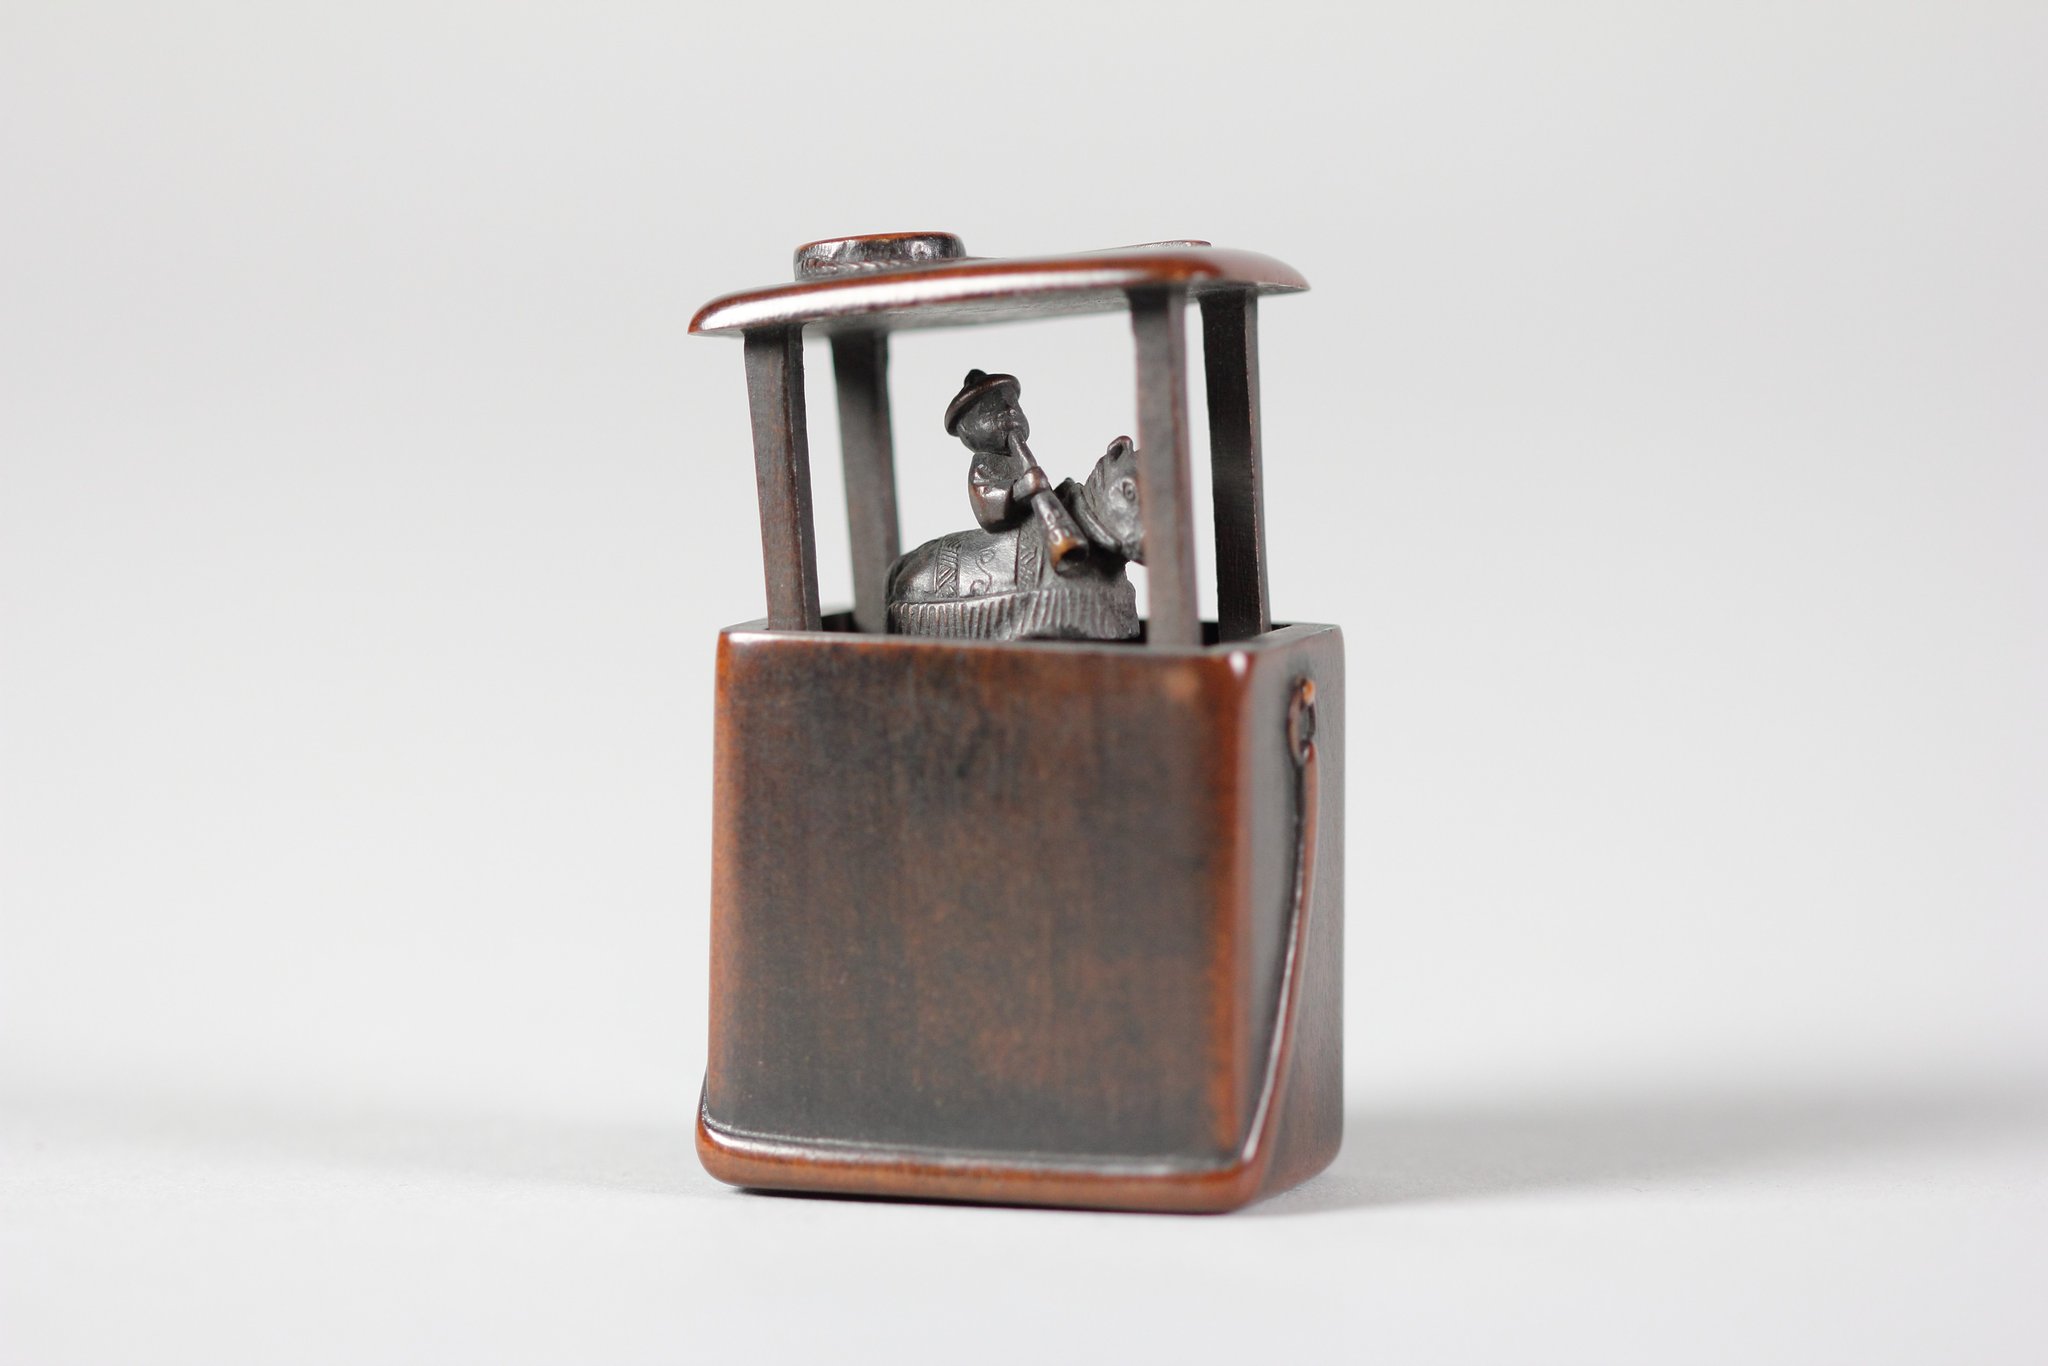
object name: netsuke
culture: japanese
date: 1701-1800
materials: wood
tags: human figures,animals